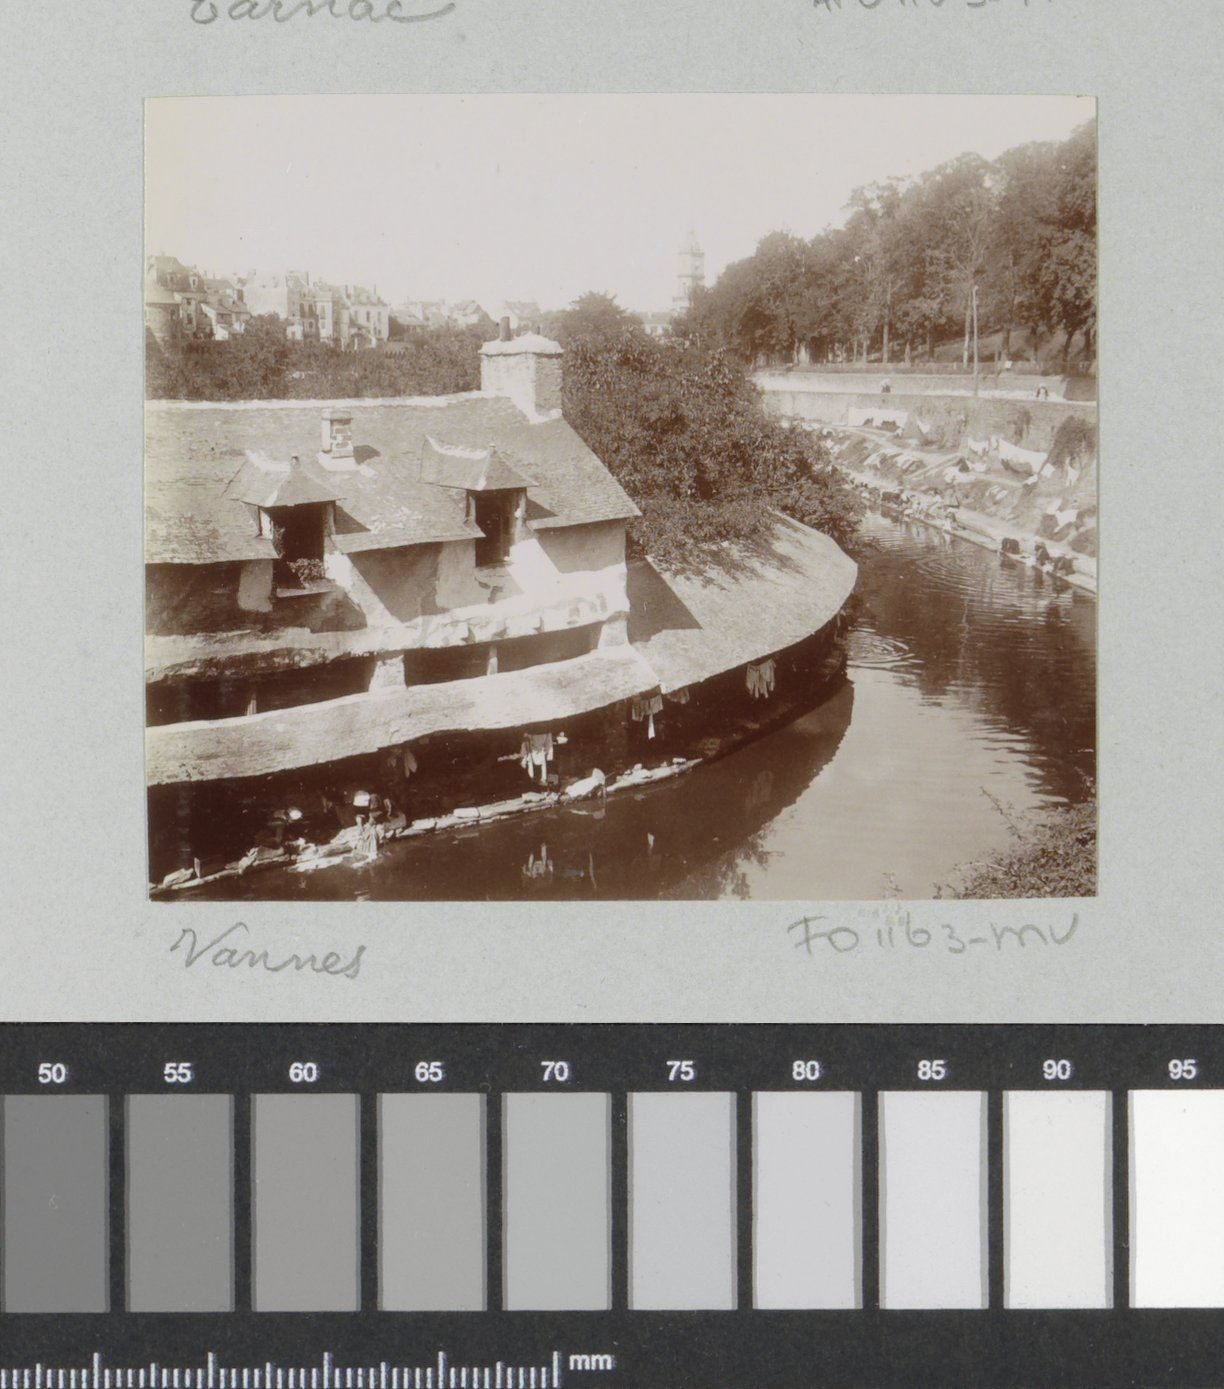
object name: photograph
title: Gezicht op de washuizen van Vannes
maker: delizy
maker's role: manufacturer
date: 1901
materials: paper, photographic support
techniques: gelatin silver print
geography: vannes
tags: building or outbuilding where laundry is done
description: Onderdeel van Fotoalbum van een Franse amateurfotograaf met opnames van uitstapjes in Frankrijk, Spanje, België, Luxemburg en Nederland, de eerste automobielen en autoraces.